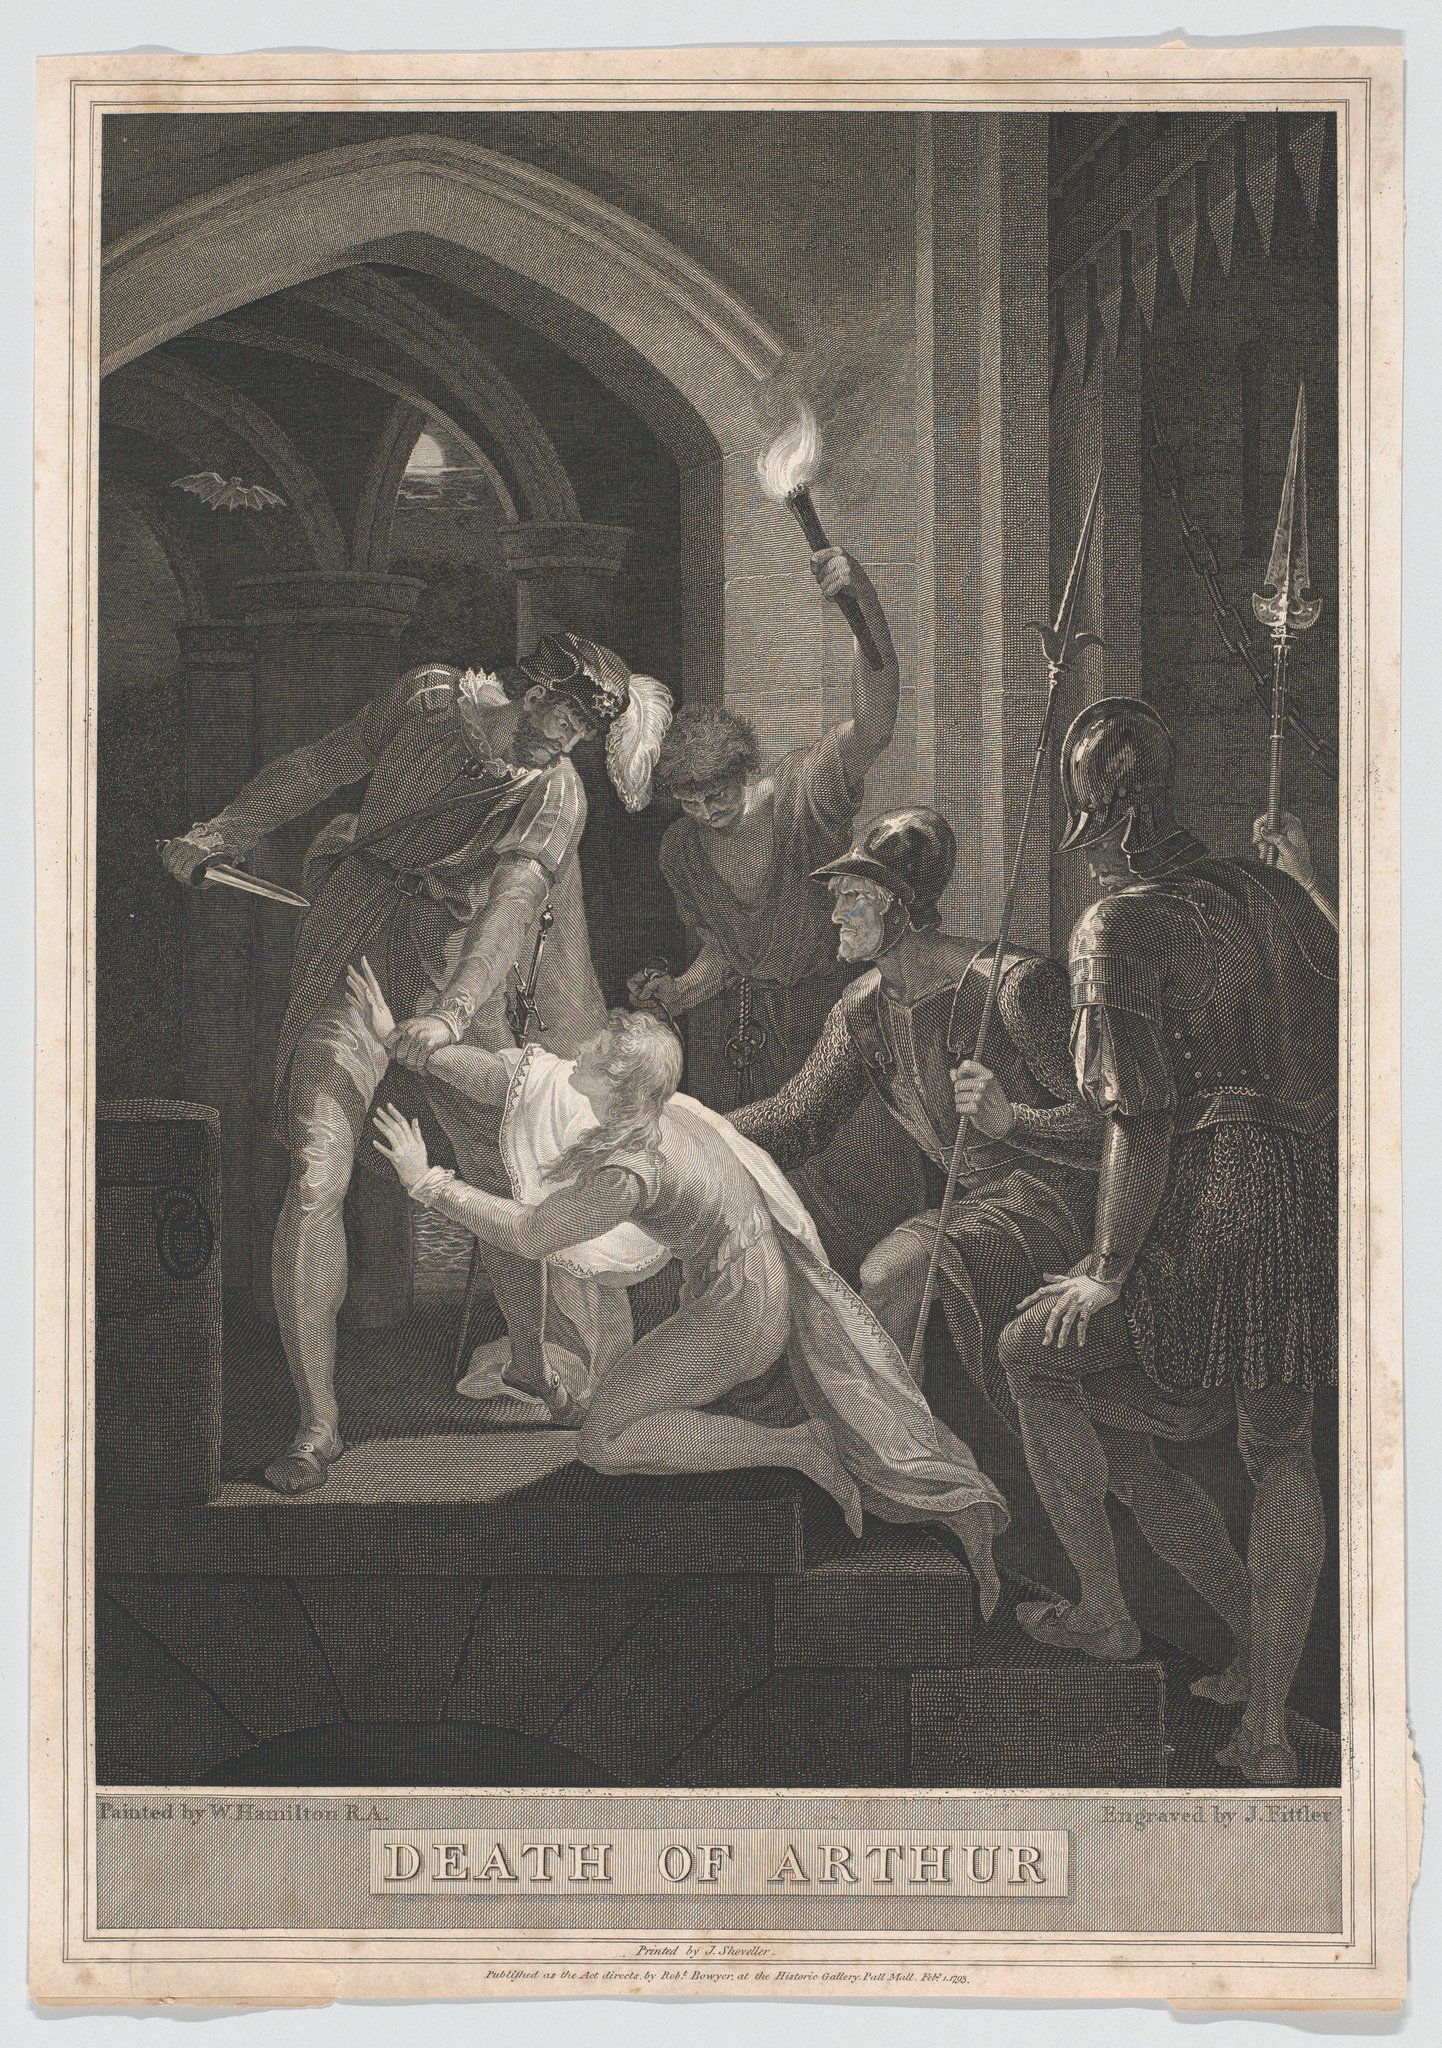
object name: print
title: The Death of Arthur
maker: james fittler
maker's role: engraver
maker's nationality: british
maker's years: 1758-1835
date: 1793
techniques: engraving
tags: daggers,spears,men,punishment